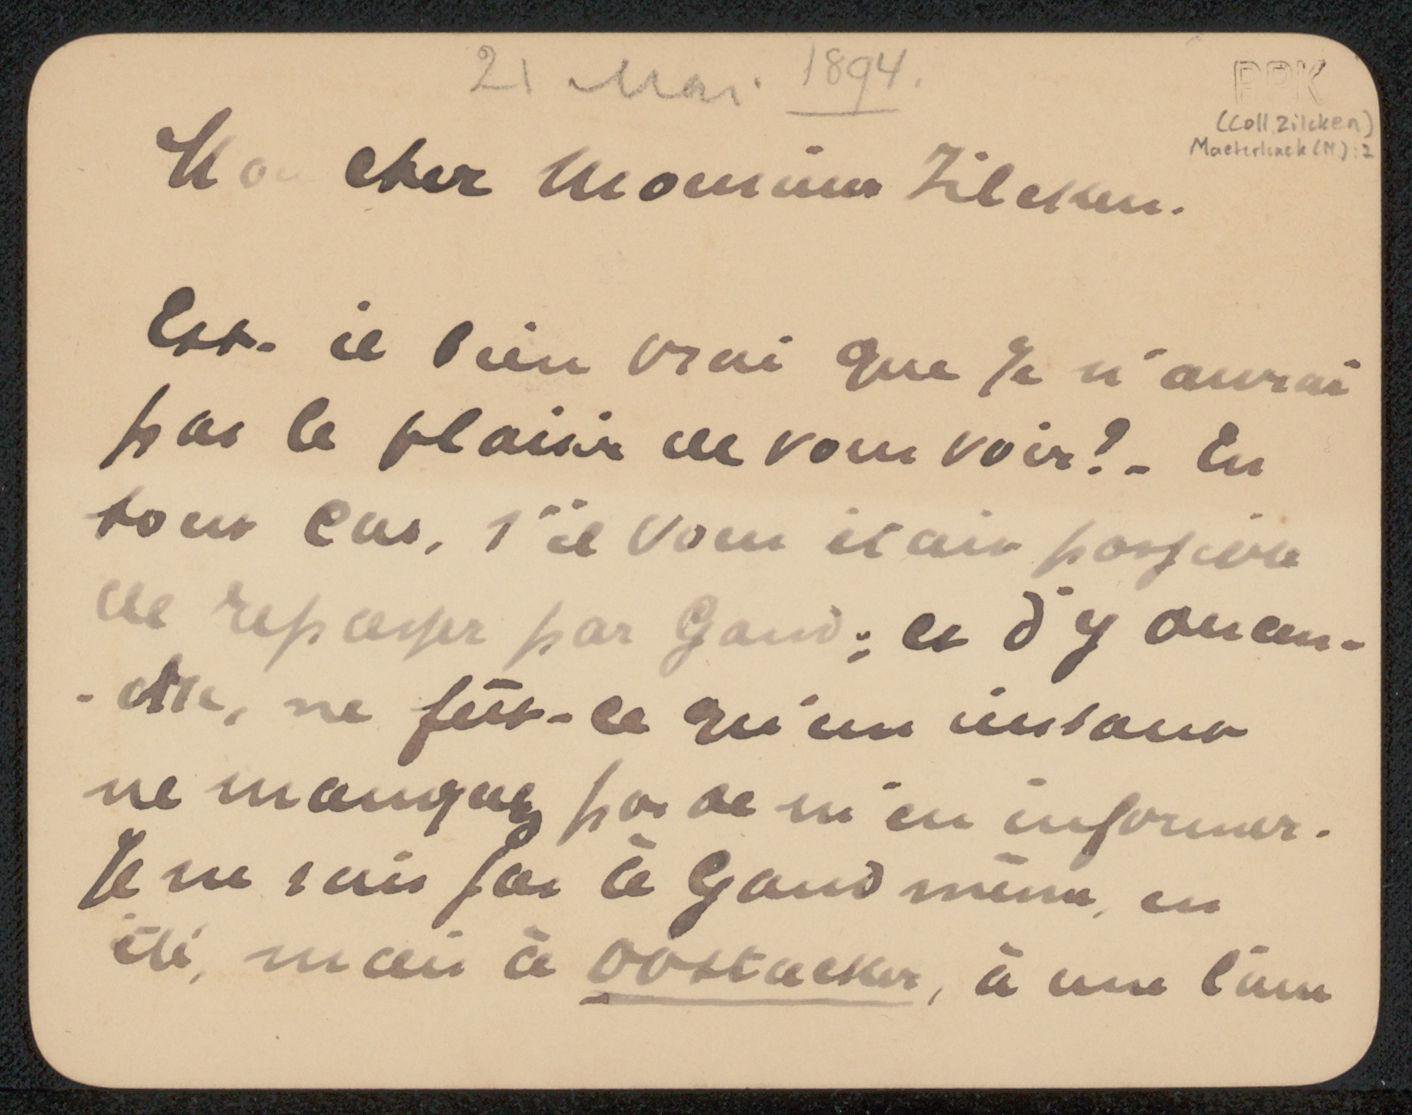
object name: letter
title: Brief aan Philip Zilcken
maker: maurice maeterlinck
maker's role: dichter, essayist, toneelschrijver, vertaler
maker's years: 1862-1949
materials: cardboard, ink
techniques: pen, writing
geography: ghent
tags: paris, octave mirbeau, the hague, painter, philip zilcken, ghent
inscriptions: collector's mark: ‘RPK’